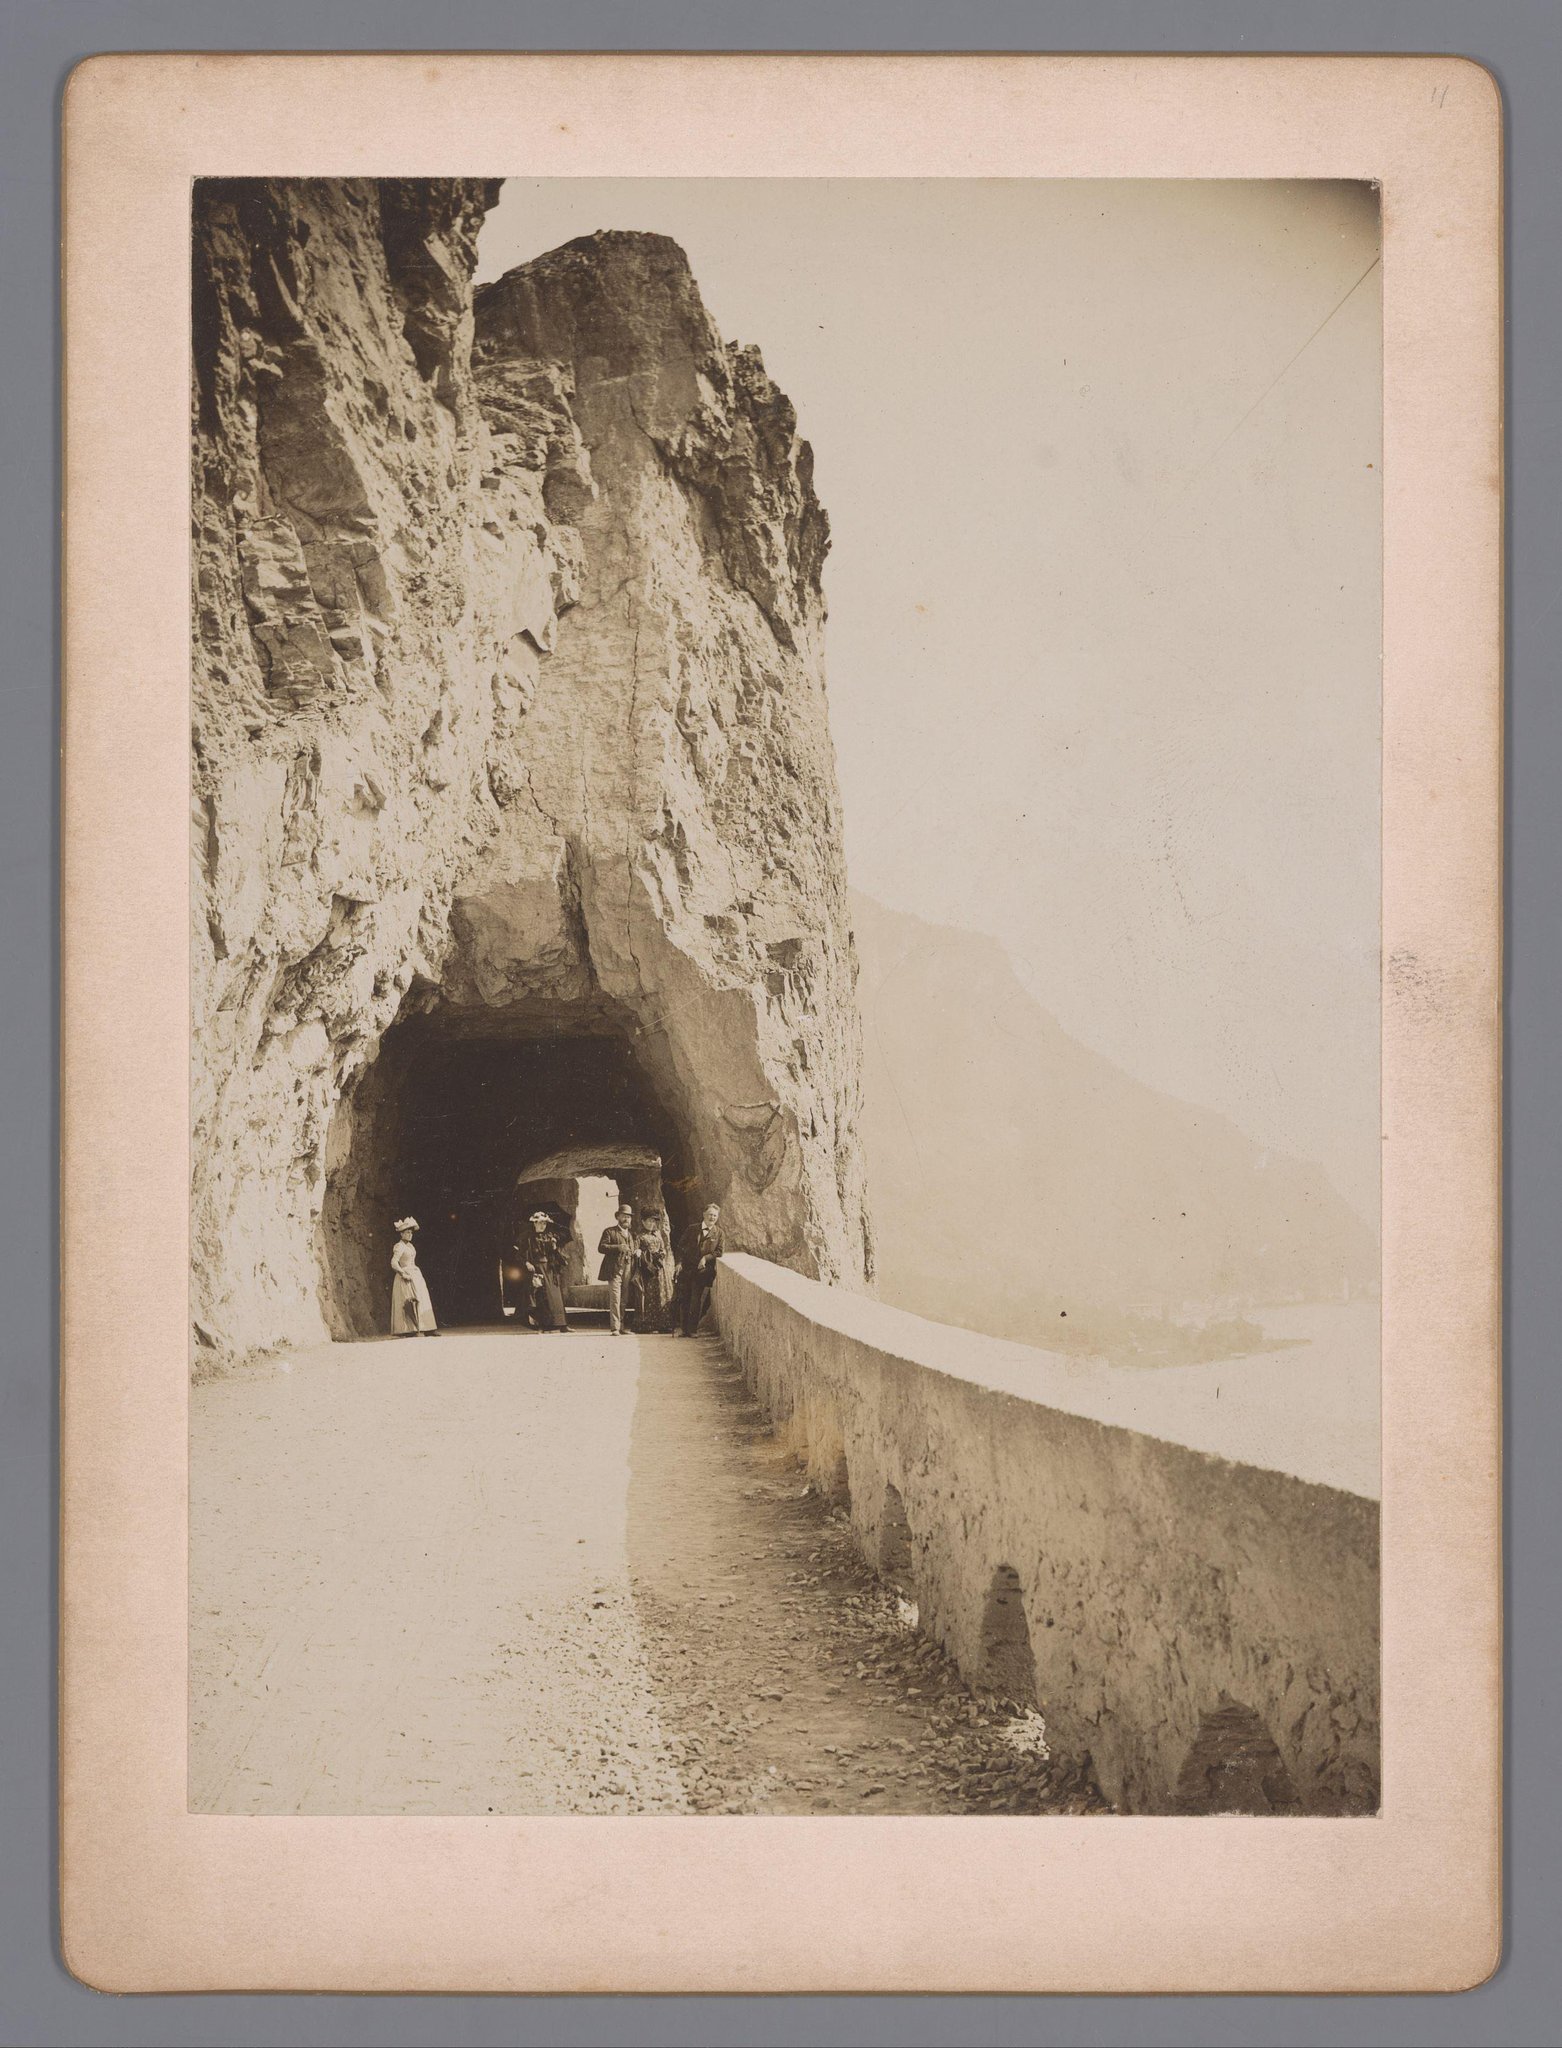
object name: photograph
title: Vijf personen op de Axenstrasse in Zwitserland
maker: Anonymous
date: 1880-1910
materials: paper, cardboard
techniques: collodion silver print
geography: uri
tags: underground road, tunnel, anonymous historical persons portrayed in a group, in a group-portrait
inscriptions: inscription: ‘Axenstrasse’